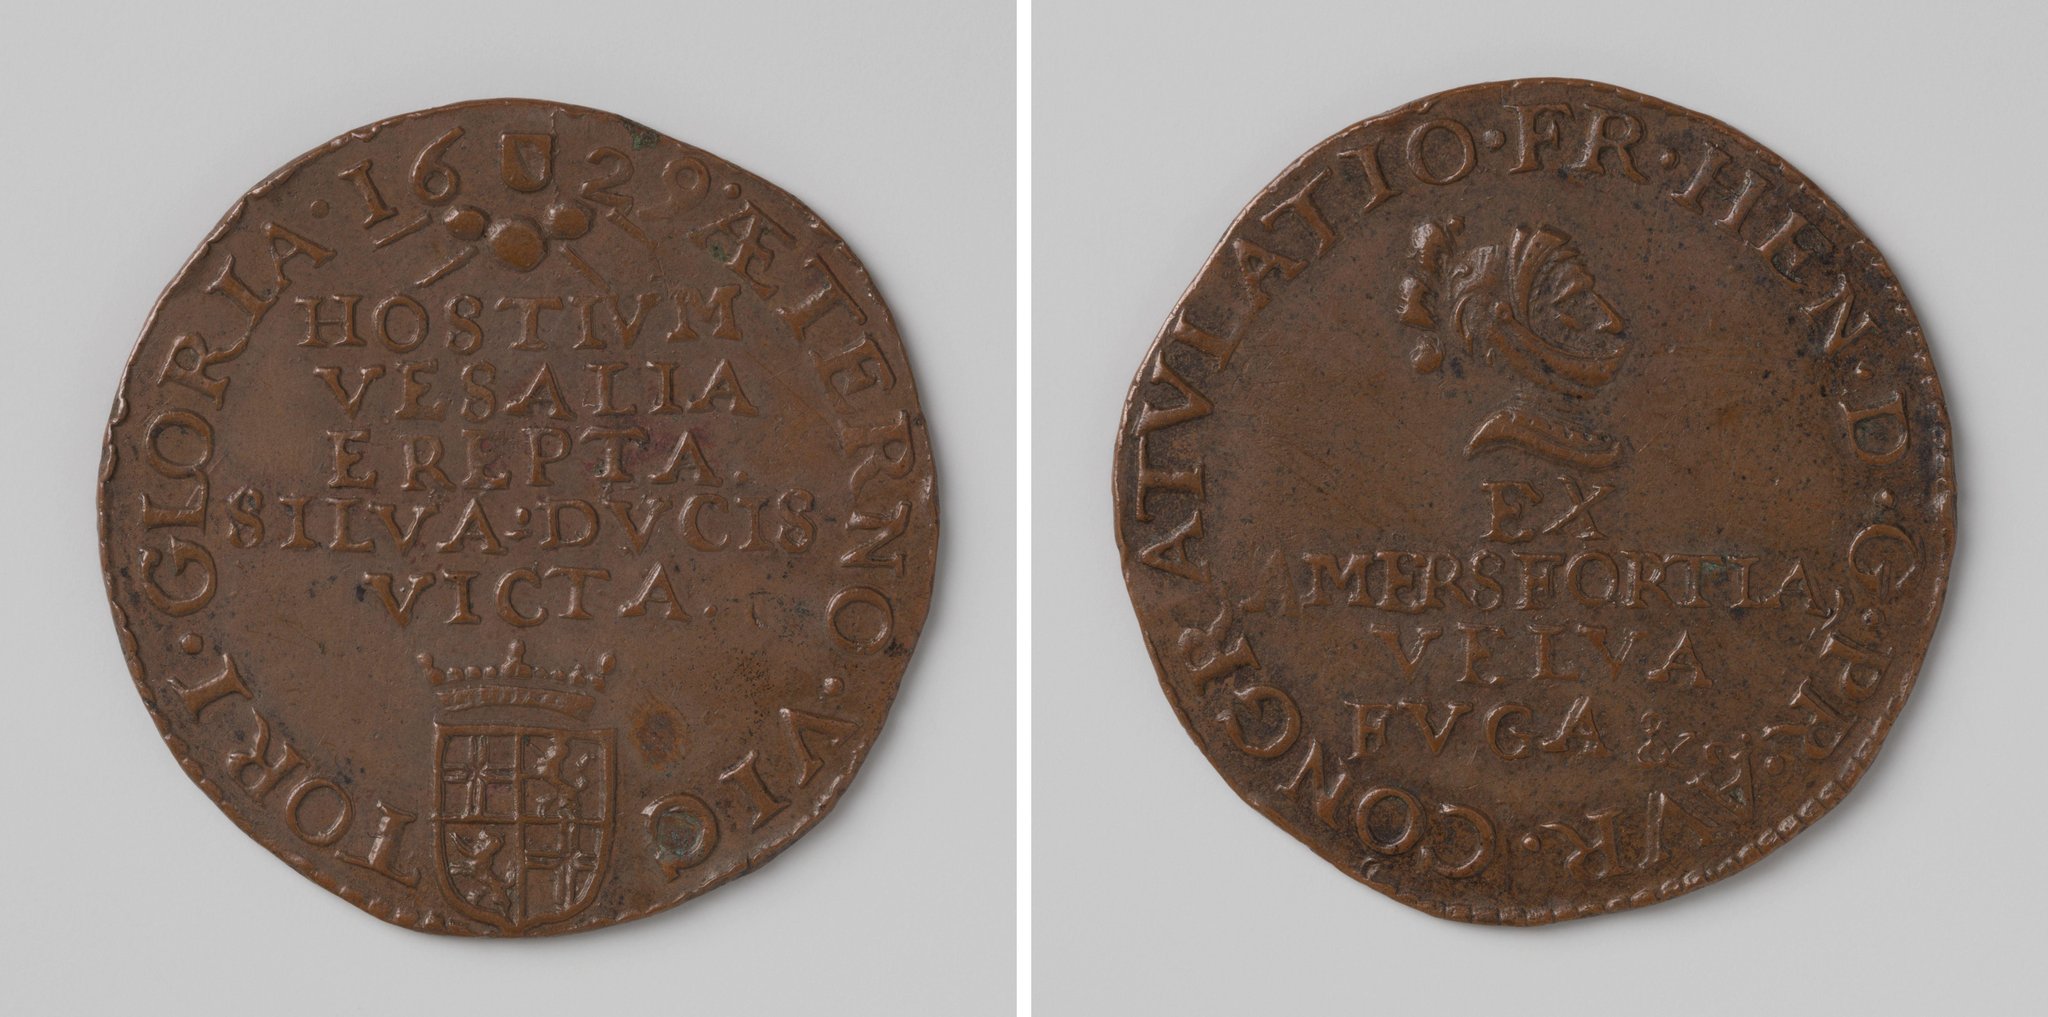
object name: jeton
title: Verdrijving van de vijand uit Amersfoort en de Veluwe en inname van 's-Hertogenbosch en Wezel door Frederik Hendrik, prins van Oranje-Nassau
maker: Anonymous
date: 1629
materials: copper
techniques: striking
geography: utrecht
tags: delft, frederick henry (prince of orange), den bosch, utrecht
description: Koperen penning. Voorzijde: opschrift boven gekroond wapenschild binnen omschrift. Keerzijde: gehelmd borststuk man boven opschrift binnen omschrift